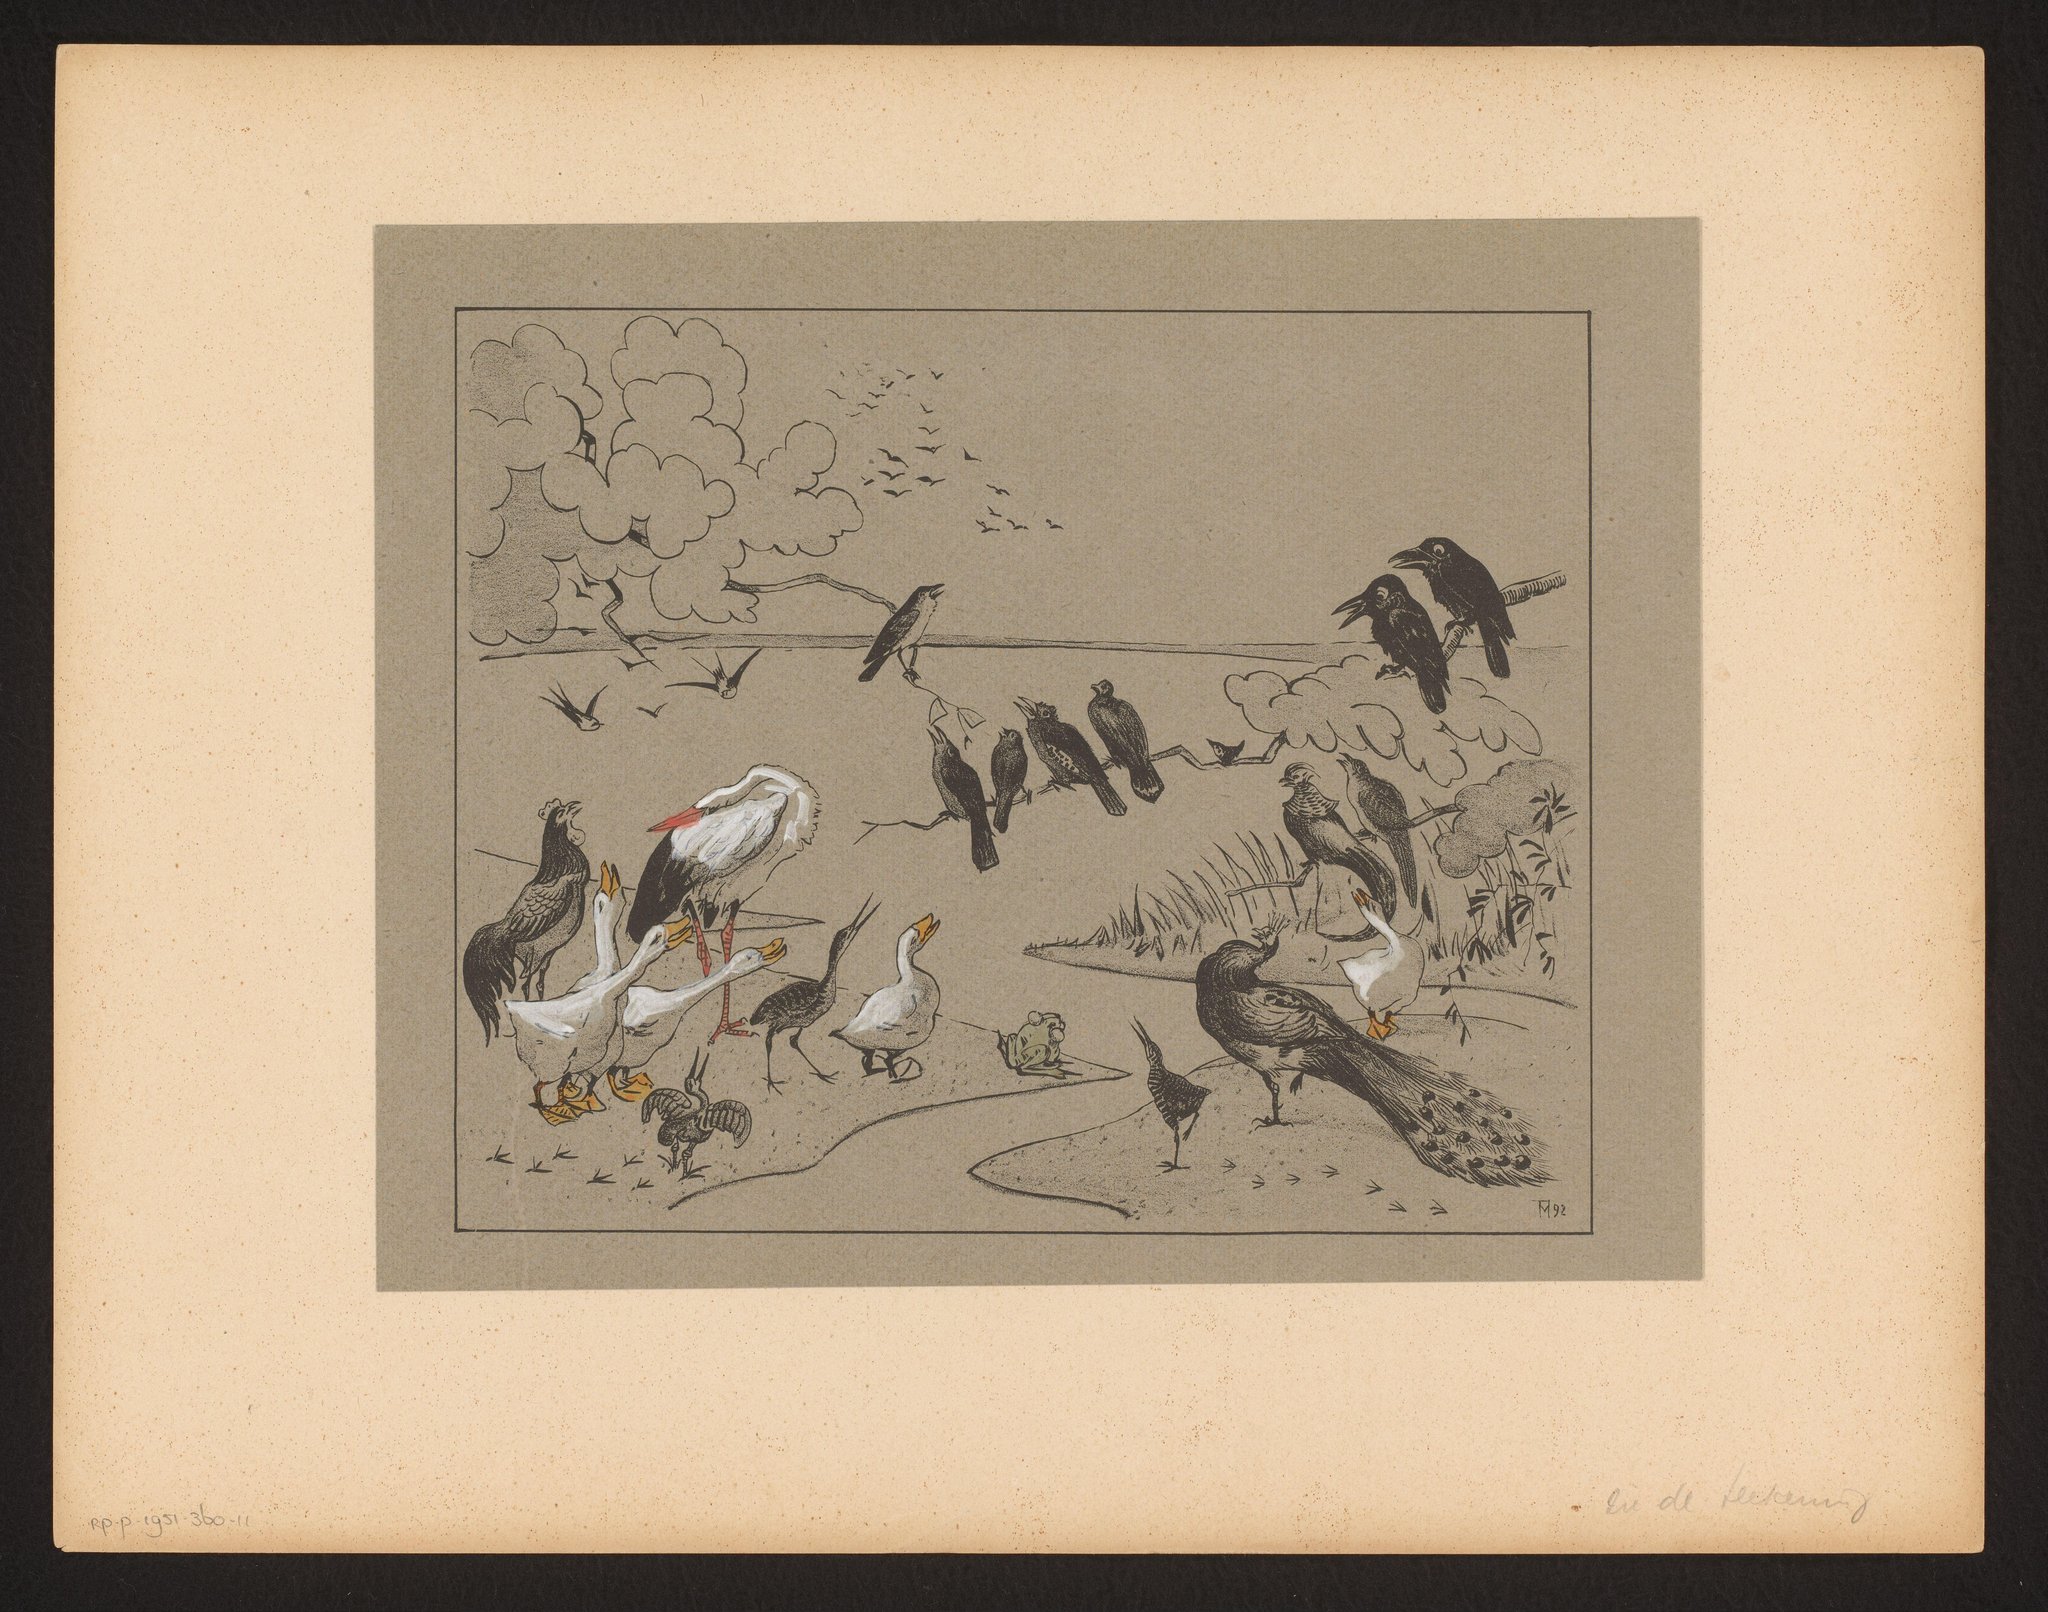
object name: print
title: Hoe de vogels aan een koning kwamen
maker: theo van hoytema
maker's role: draughtsman, painter, print maker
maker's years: 1863-1917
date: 1892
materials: paper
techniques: hand coloring, lithograph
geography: the hague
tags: tailless amphibians: frog, shore-birds and wading-birds: stork, song-birds: crow, song-birds: swallow, ornamental birds: peacock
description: Onder andere ganzen, een pauw, kraaien, een haan en zwaluwen.